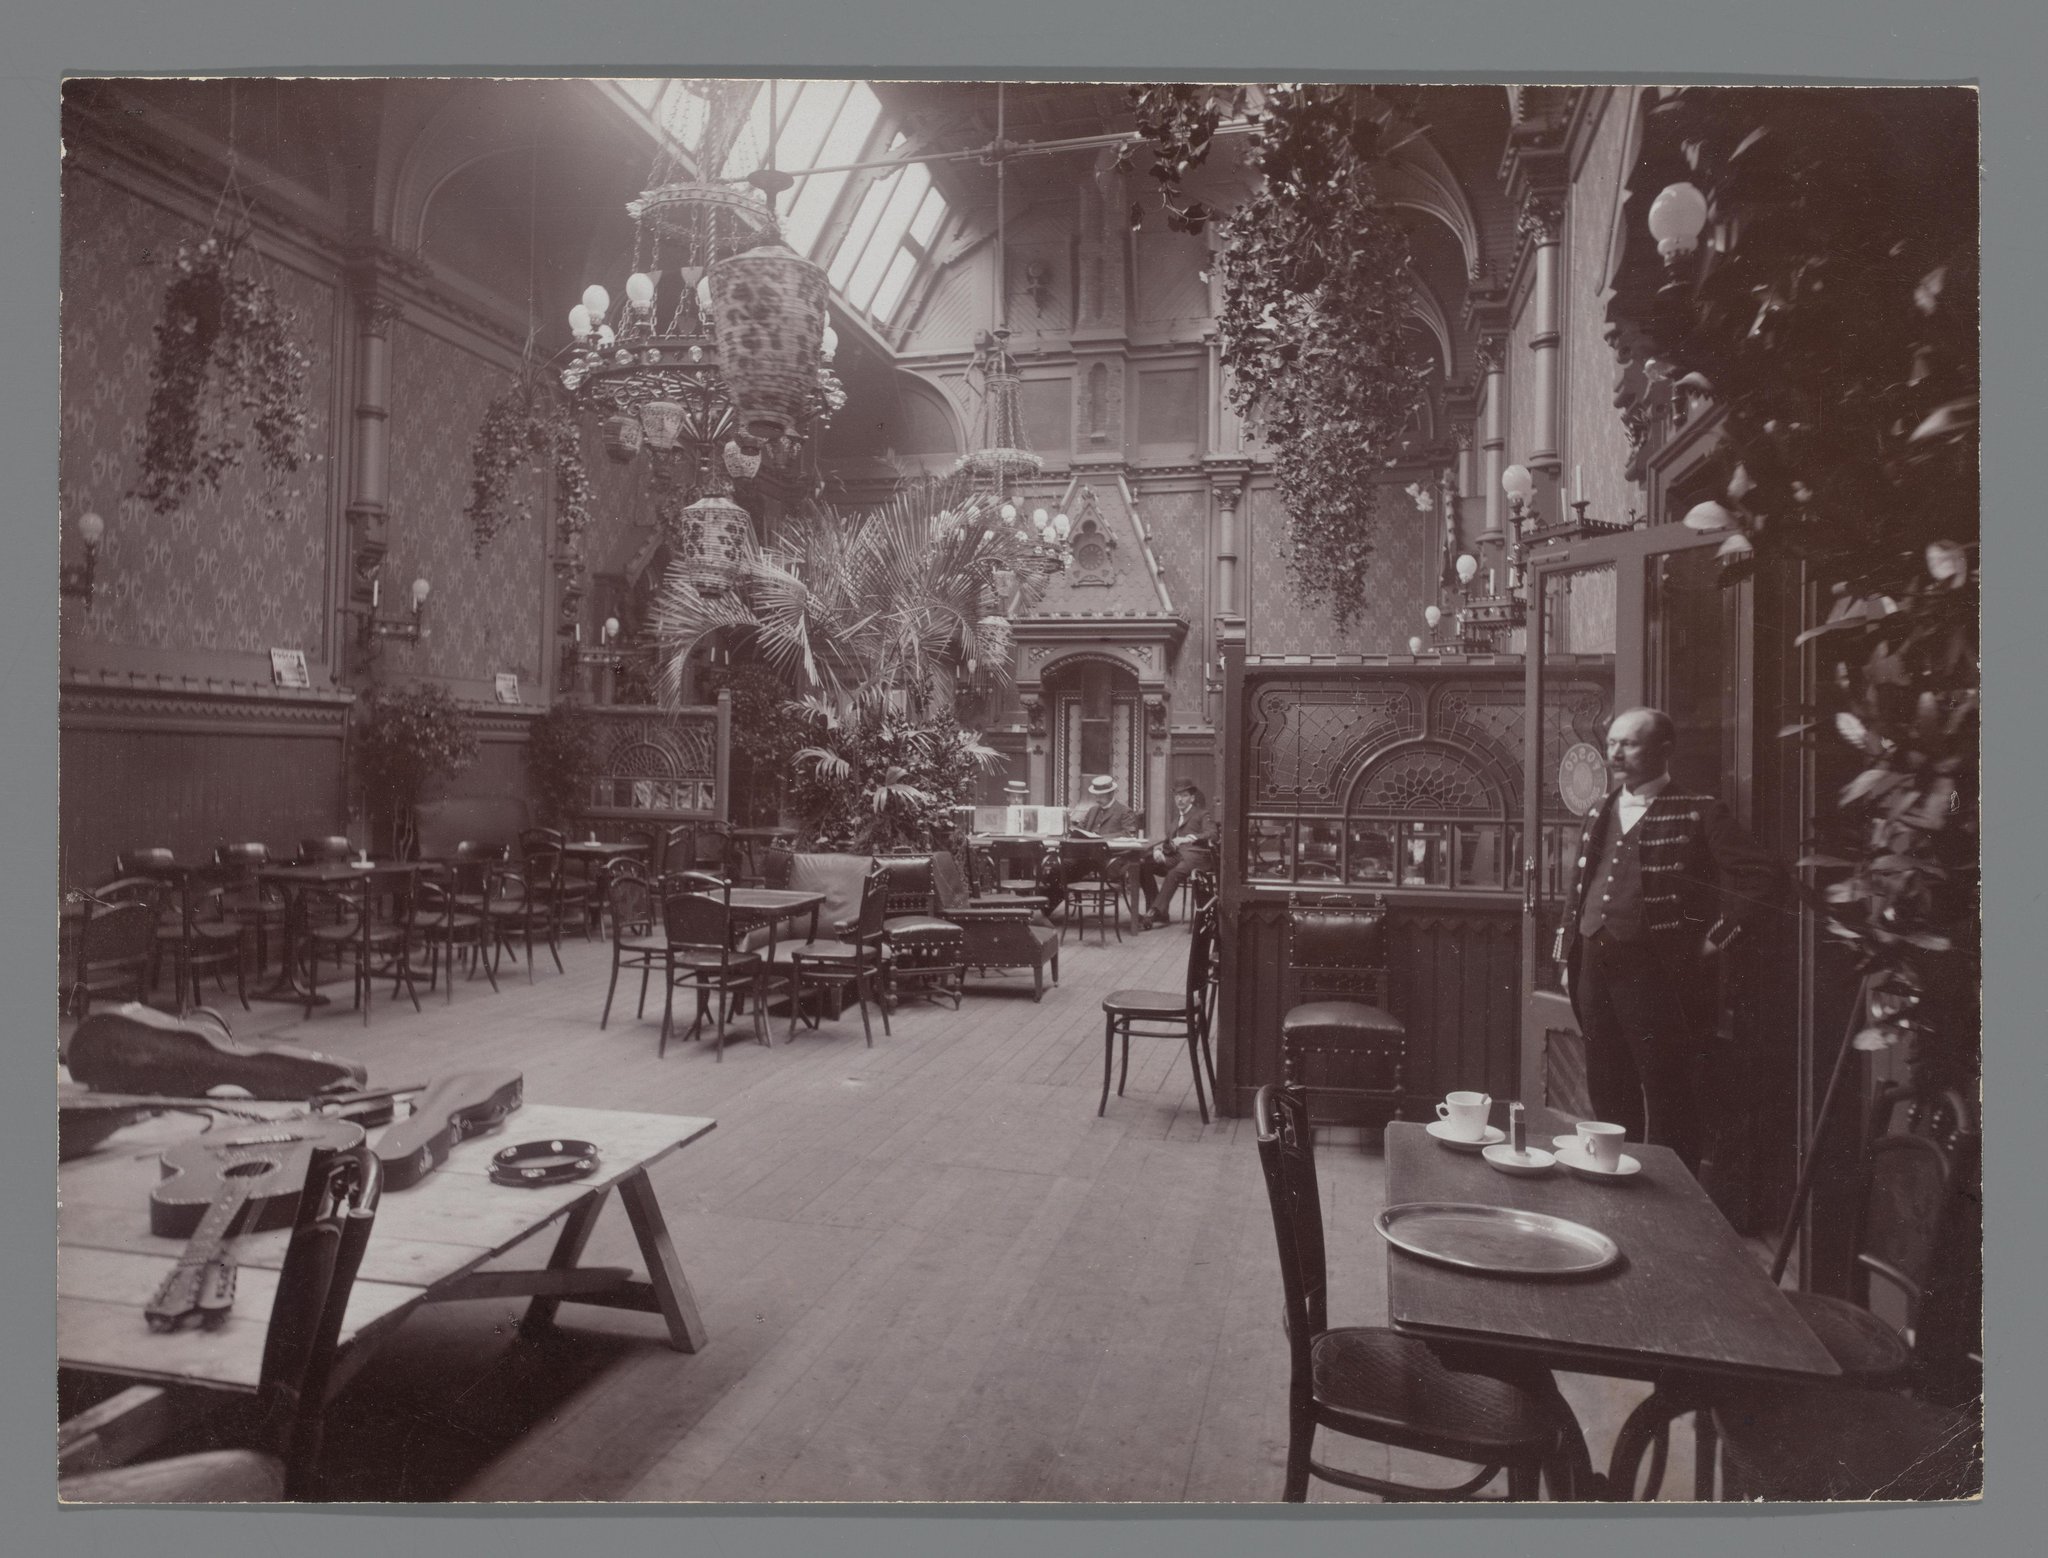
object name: photograph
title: Gezicht op een zaal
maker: Anonymous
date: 1906-1907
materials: cardboard, photographic support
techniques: collodion silver print